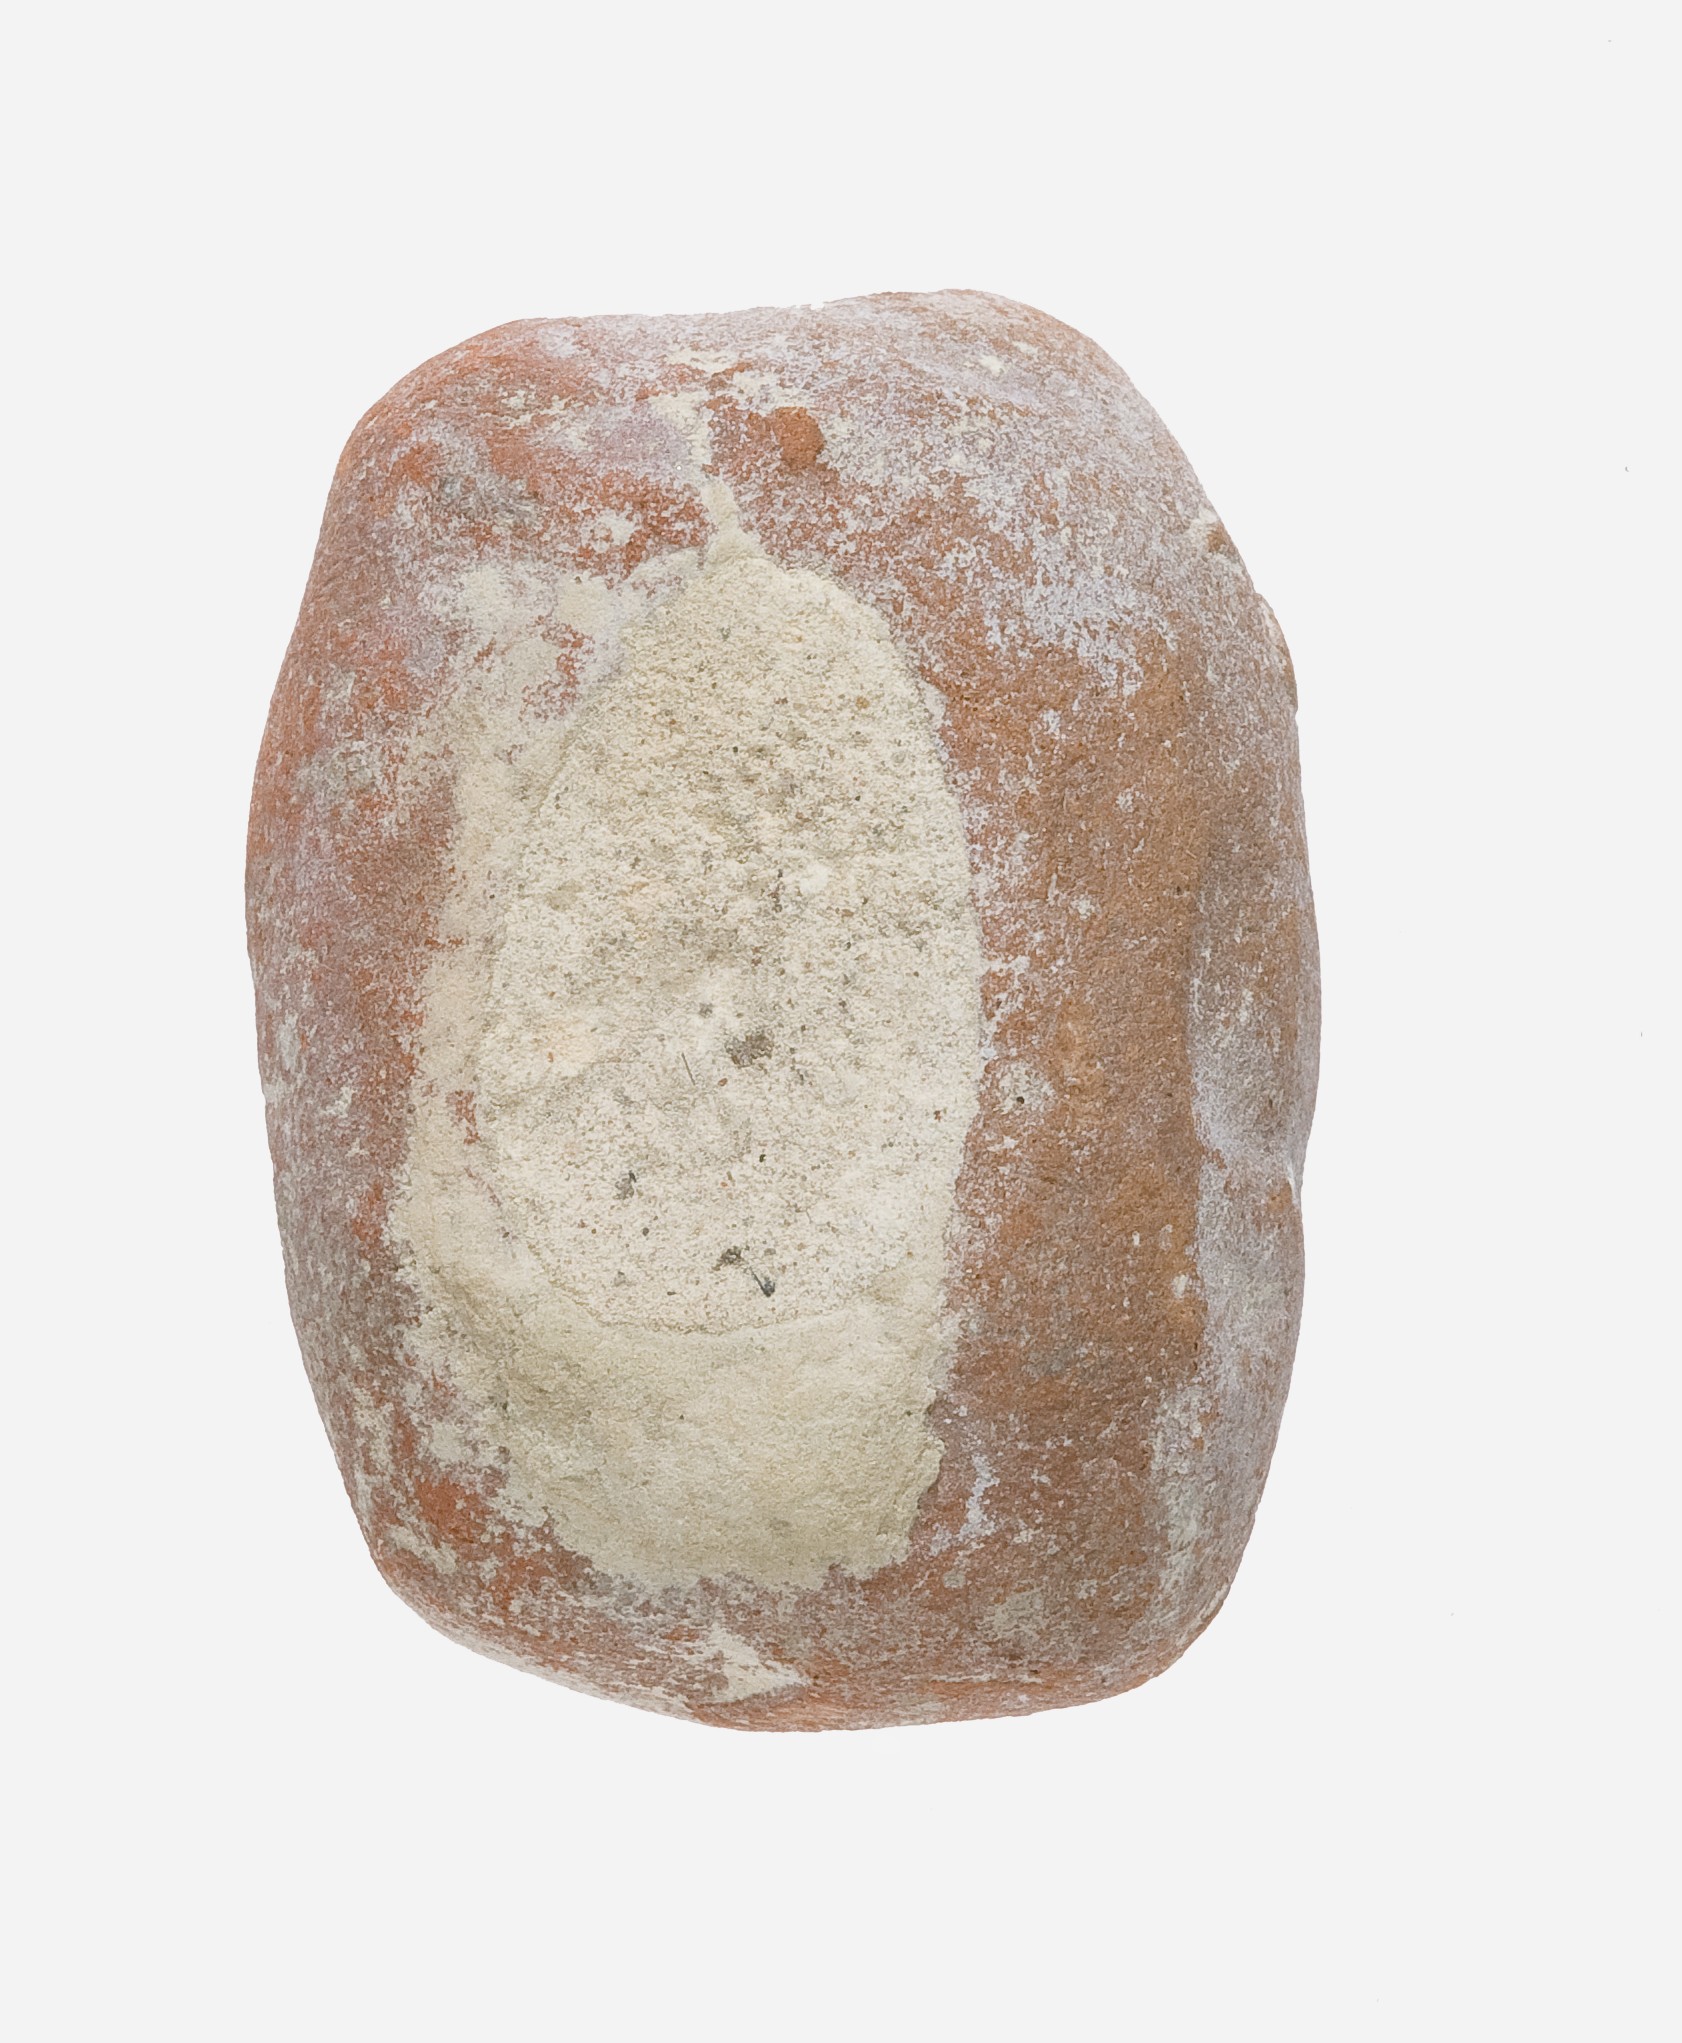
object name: mold, unfired frit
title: Mold with Unfired Frit Still Present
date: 1390-1352 BCE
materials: pottery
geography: egypt